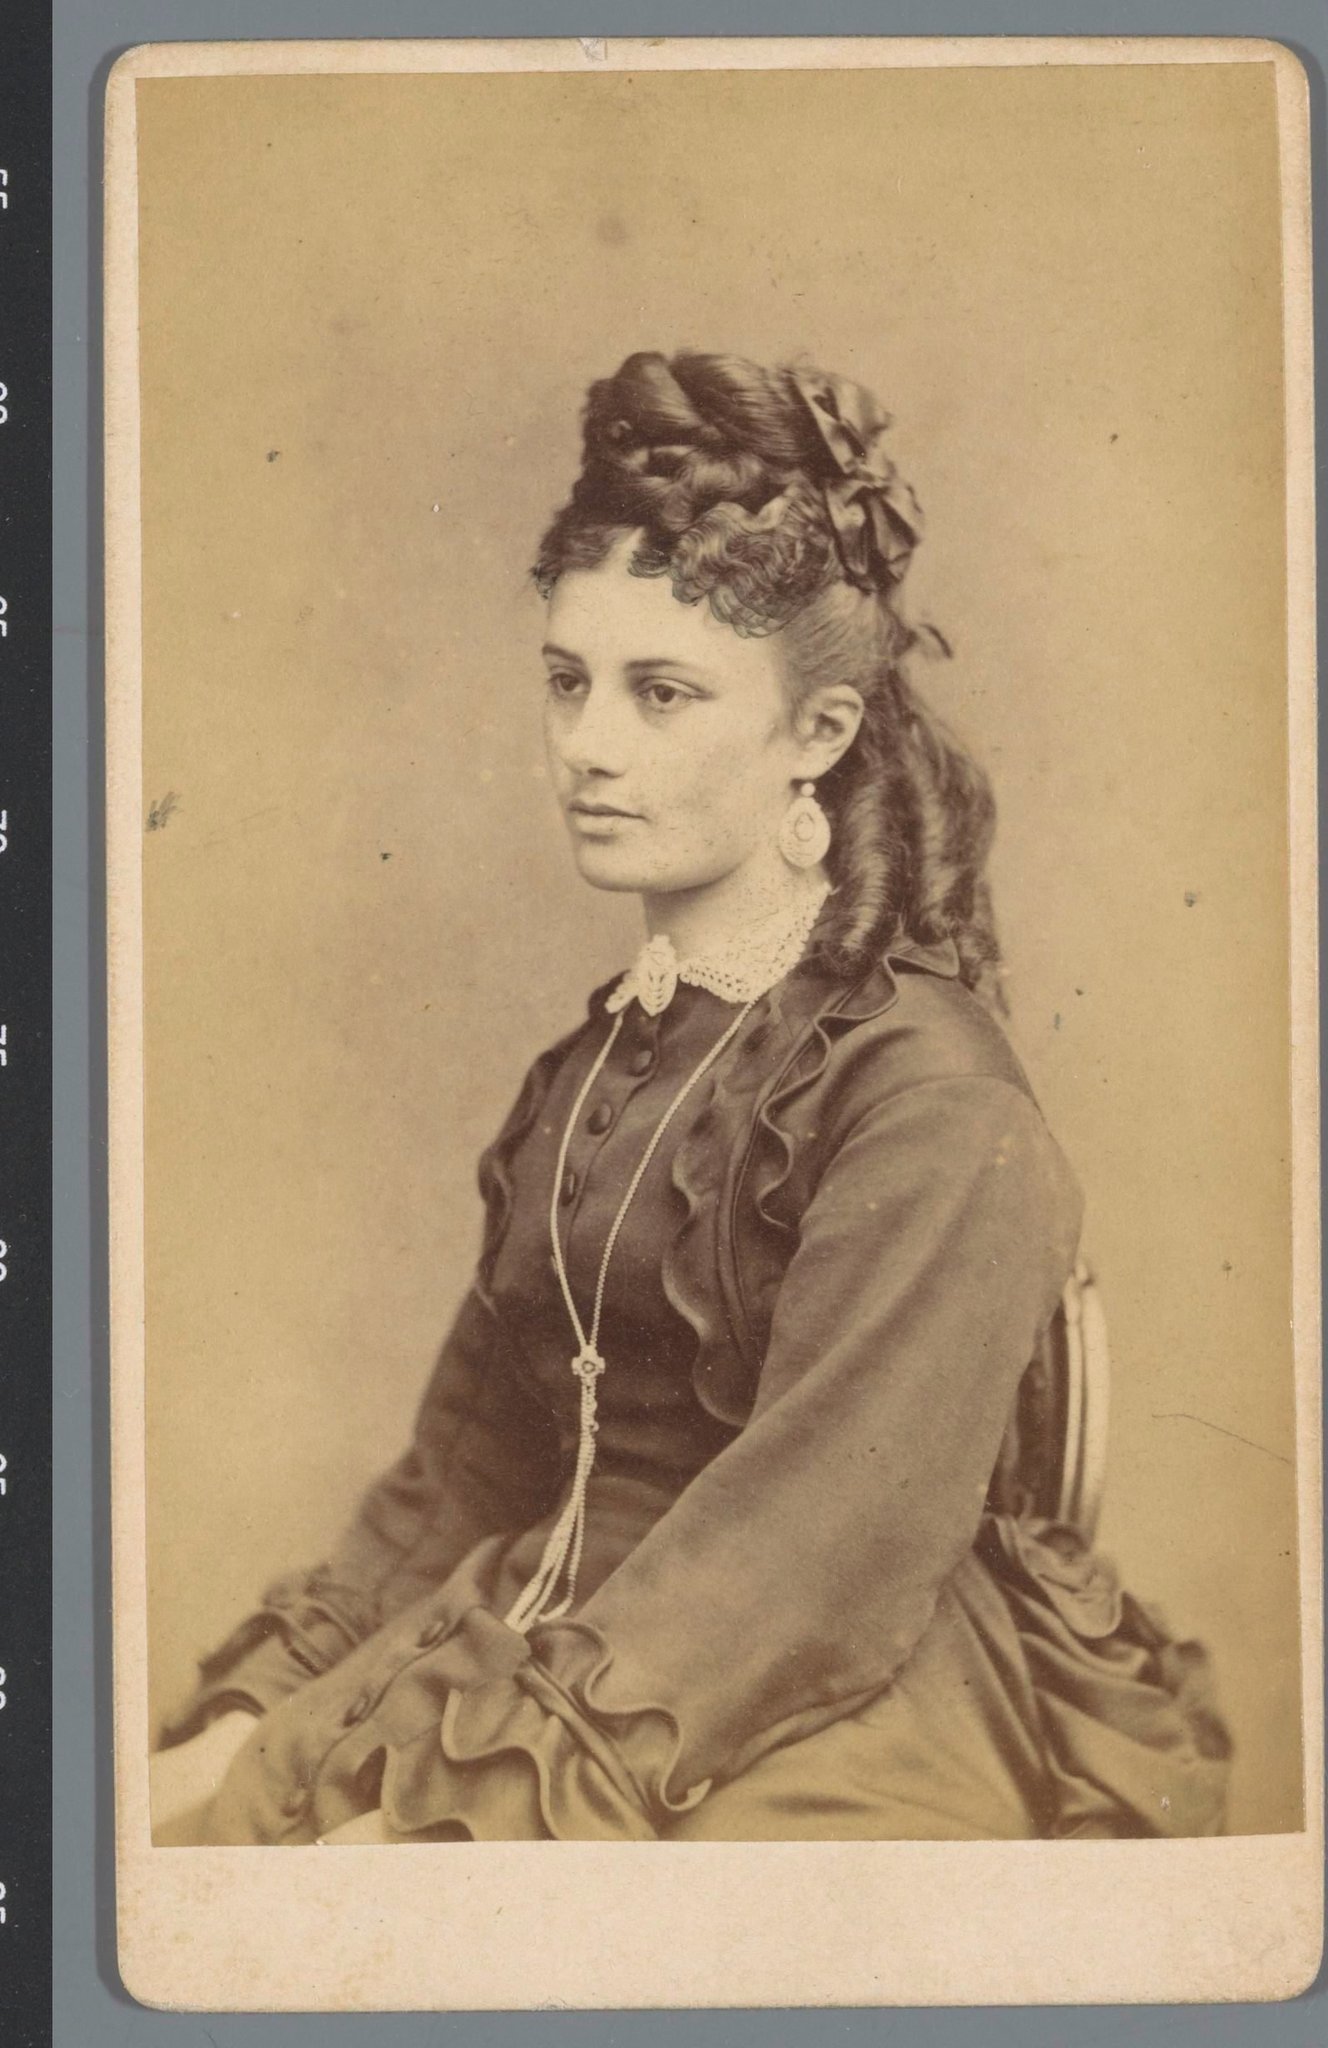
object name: photograph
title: Portret van een onbekende jonge vrouw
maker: leonard stollenwerk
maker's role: fotograaf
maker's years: 1829-1910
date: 1864-1883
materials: cardboard, paper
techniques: albumen print, retouching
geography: den bosch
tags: adolescent, young woman, maiden, anonymous historical person portrayed, den bosch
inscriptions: inscription: ‘Photographisch/ Atelier/ L. Stollenwerk/ 's Bosch’